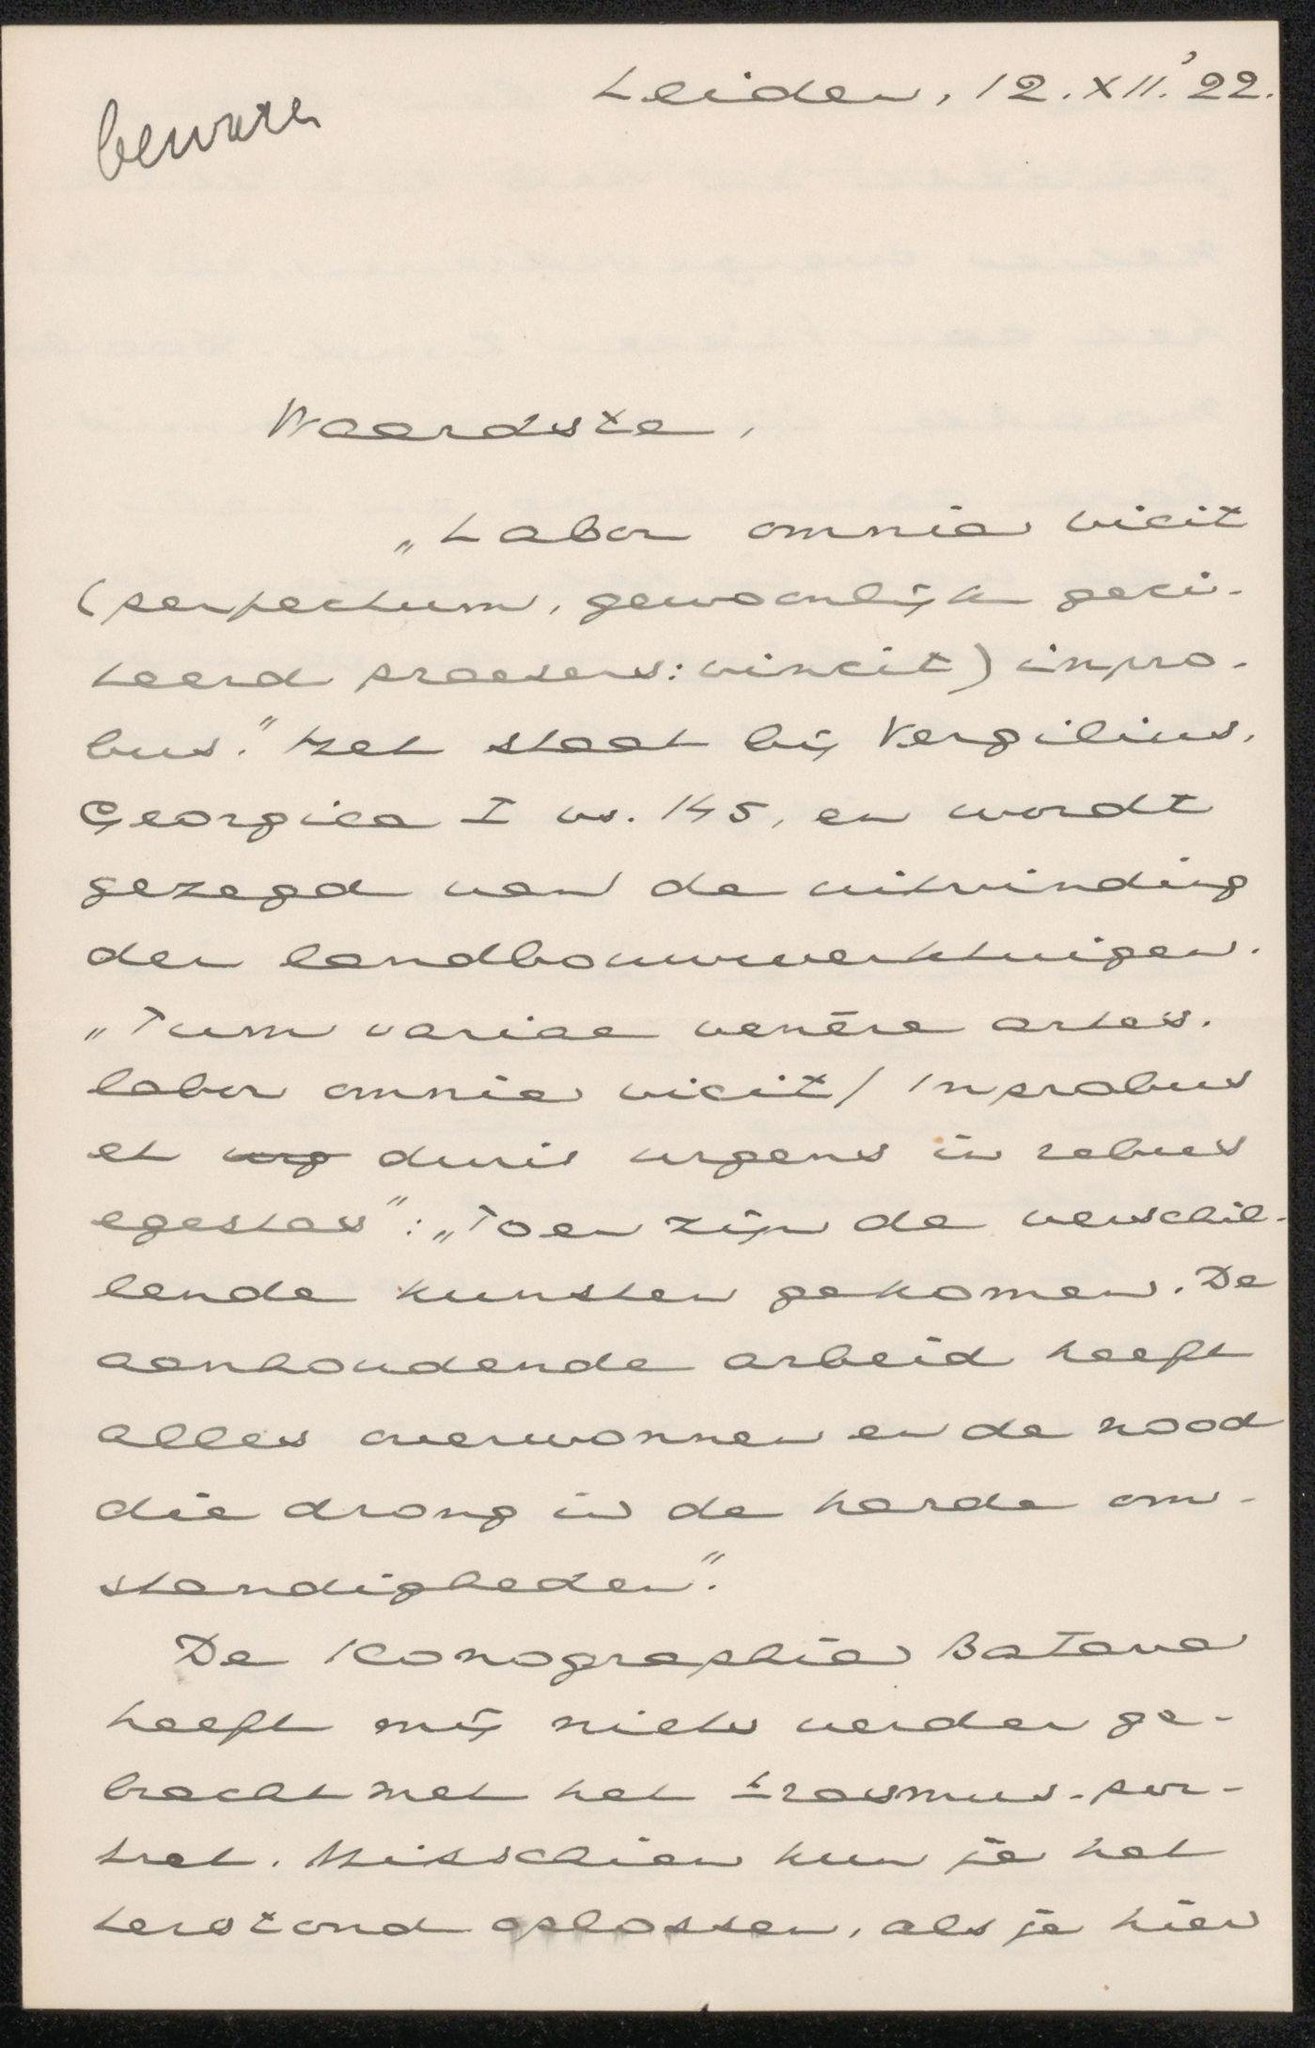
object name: letter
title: Brief aan Jan Veth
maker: johan huizinga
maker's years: 1872-1945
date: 1922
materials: ink, paper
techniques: pen, writing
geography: leiden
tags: dordrecht, painter, print maker, draughtsman, designer, jan veth, paris, applied arts, arts and crafts; industrial design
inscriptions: collector's mark: ‘RPK’, watermark